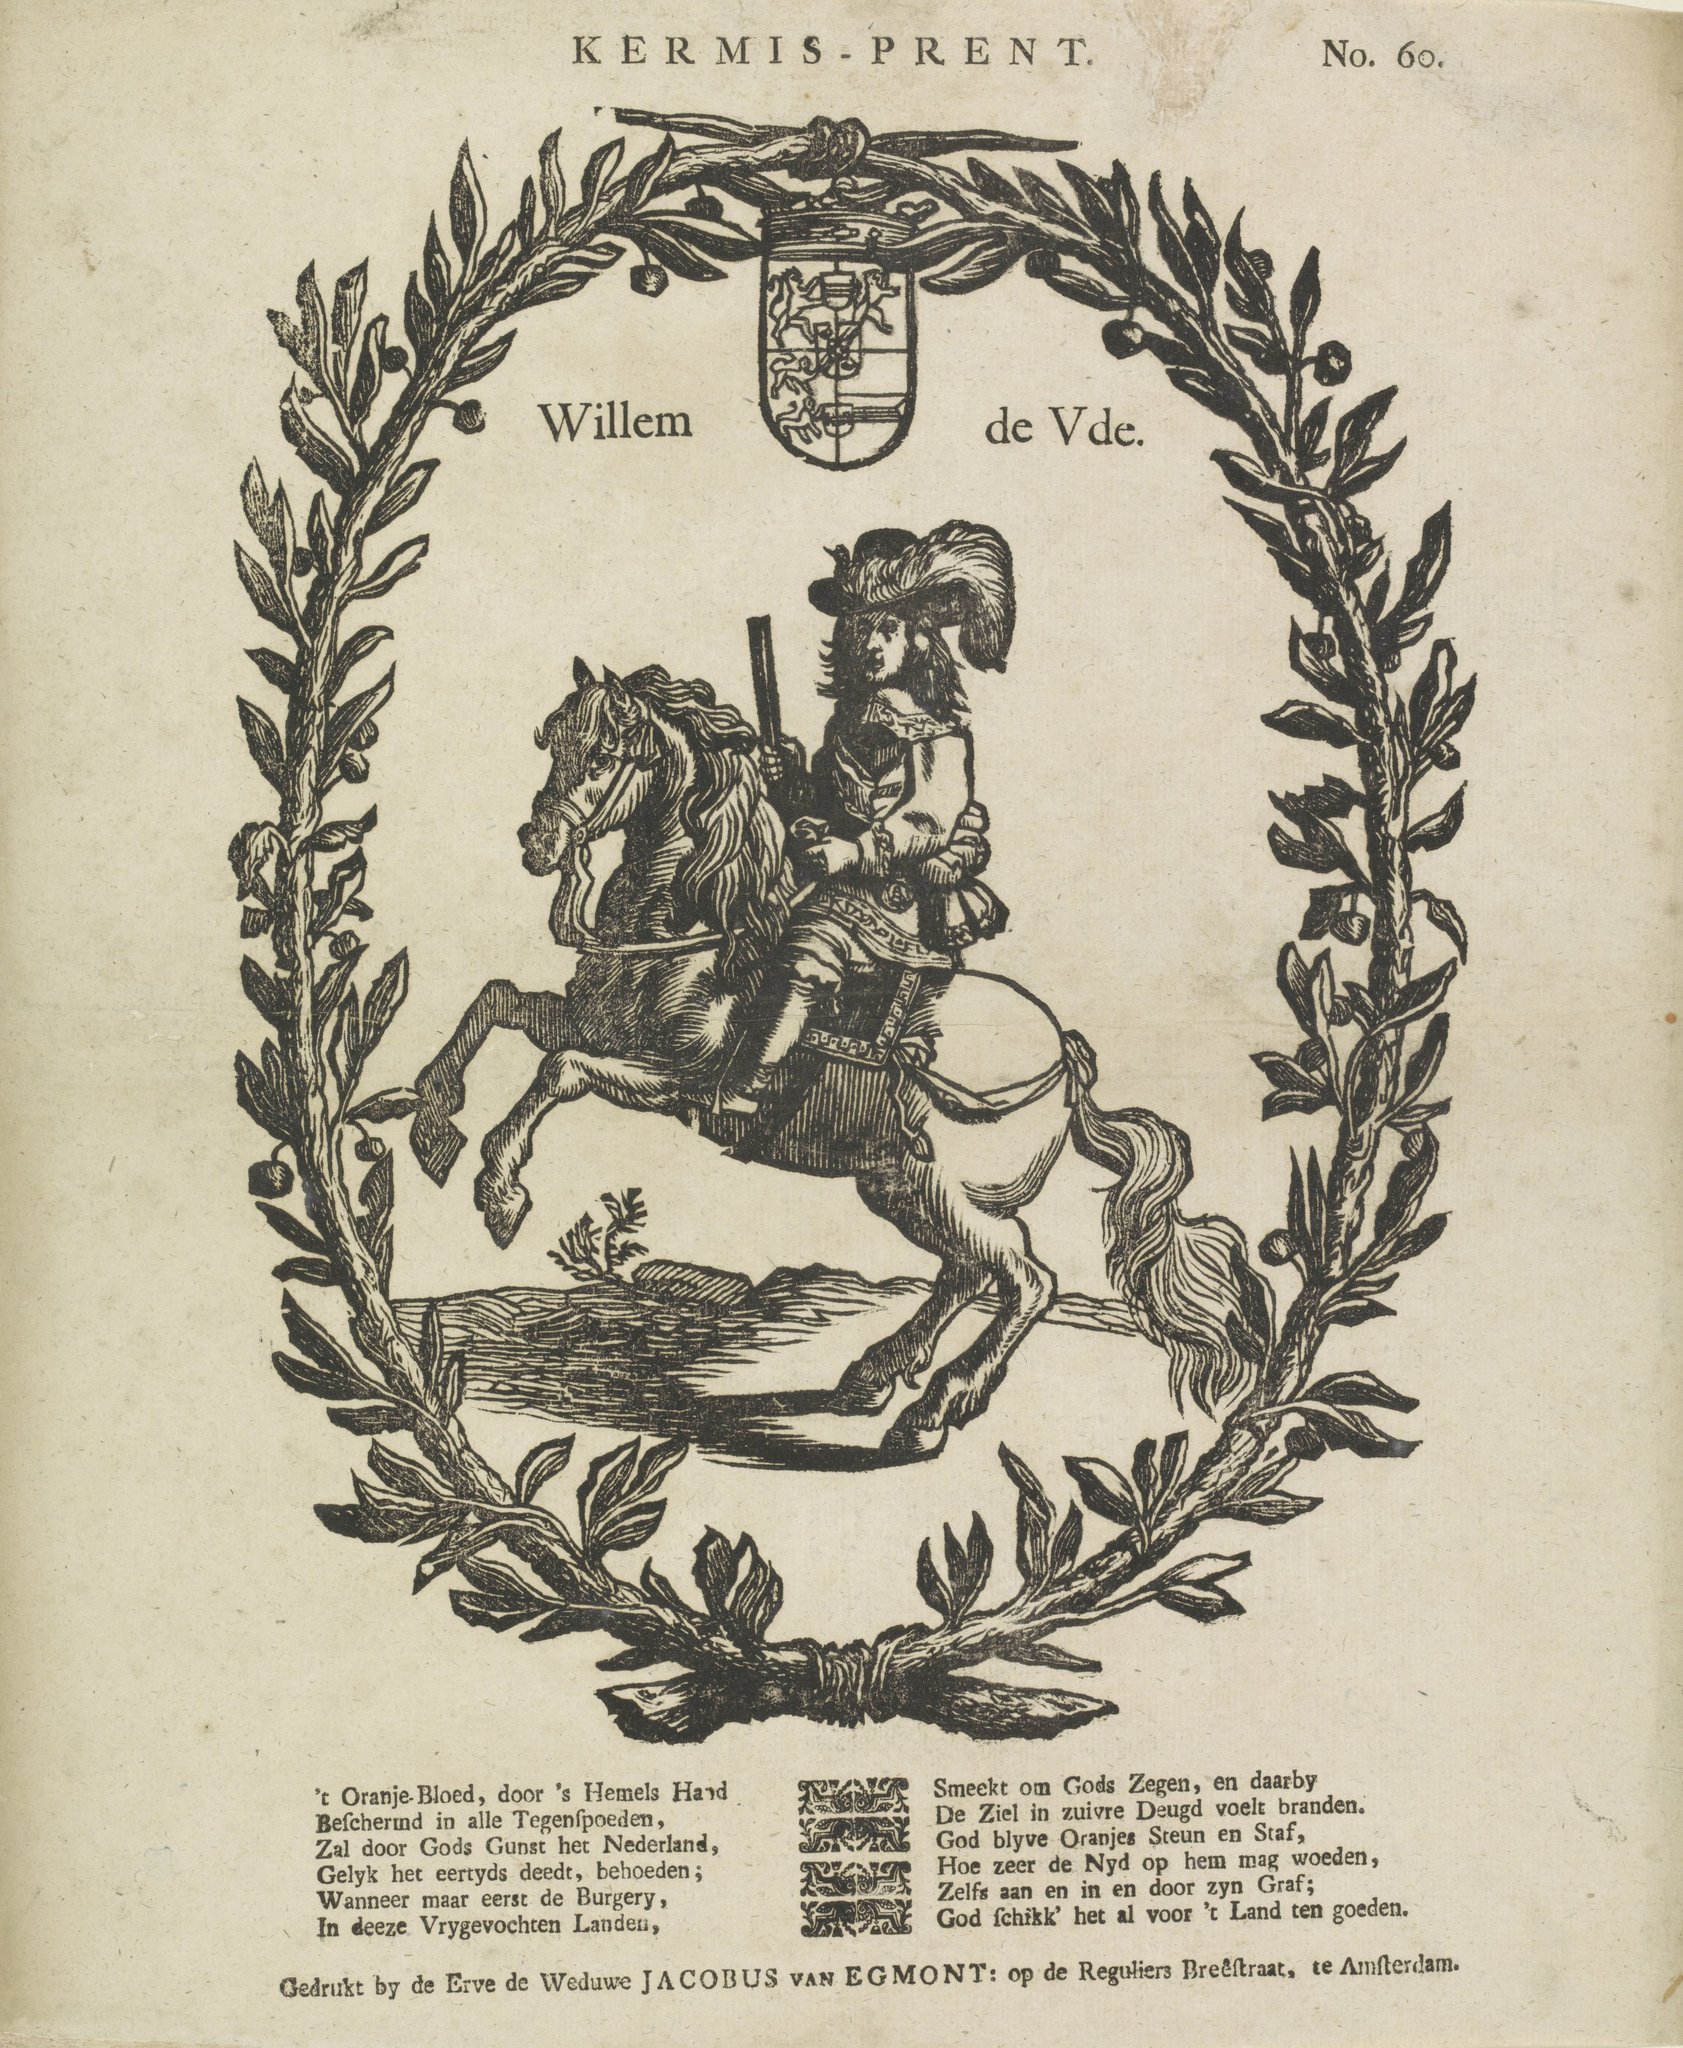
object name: popular print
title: Kermis-prent / Willem de Vde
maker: Anonymous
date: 1761-1804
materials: paper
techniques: letterpress printing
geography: amsterdam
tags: the hague, william v (prince of orange), equestrian state-portrait, armorial bearing, heraldry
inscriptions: collector's mark: Lugt 2760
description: Ruiterportret van Willem V in een ovale sierlijst van oranjeboomtakken. Midden boven een wapenschild. Onder de voorstelling een twaalfregelig vers in twee kolommen. Genummerd rechtsboven: No. 60.